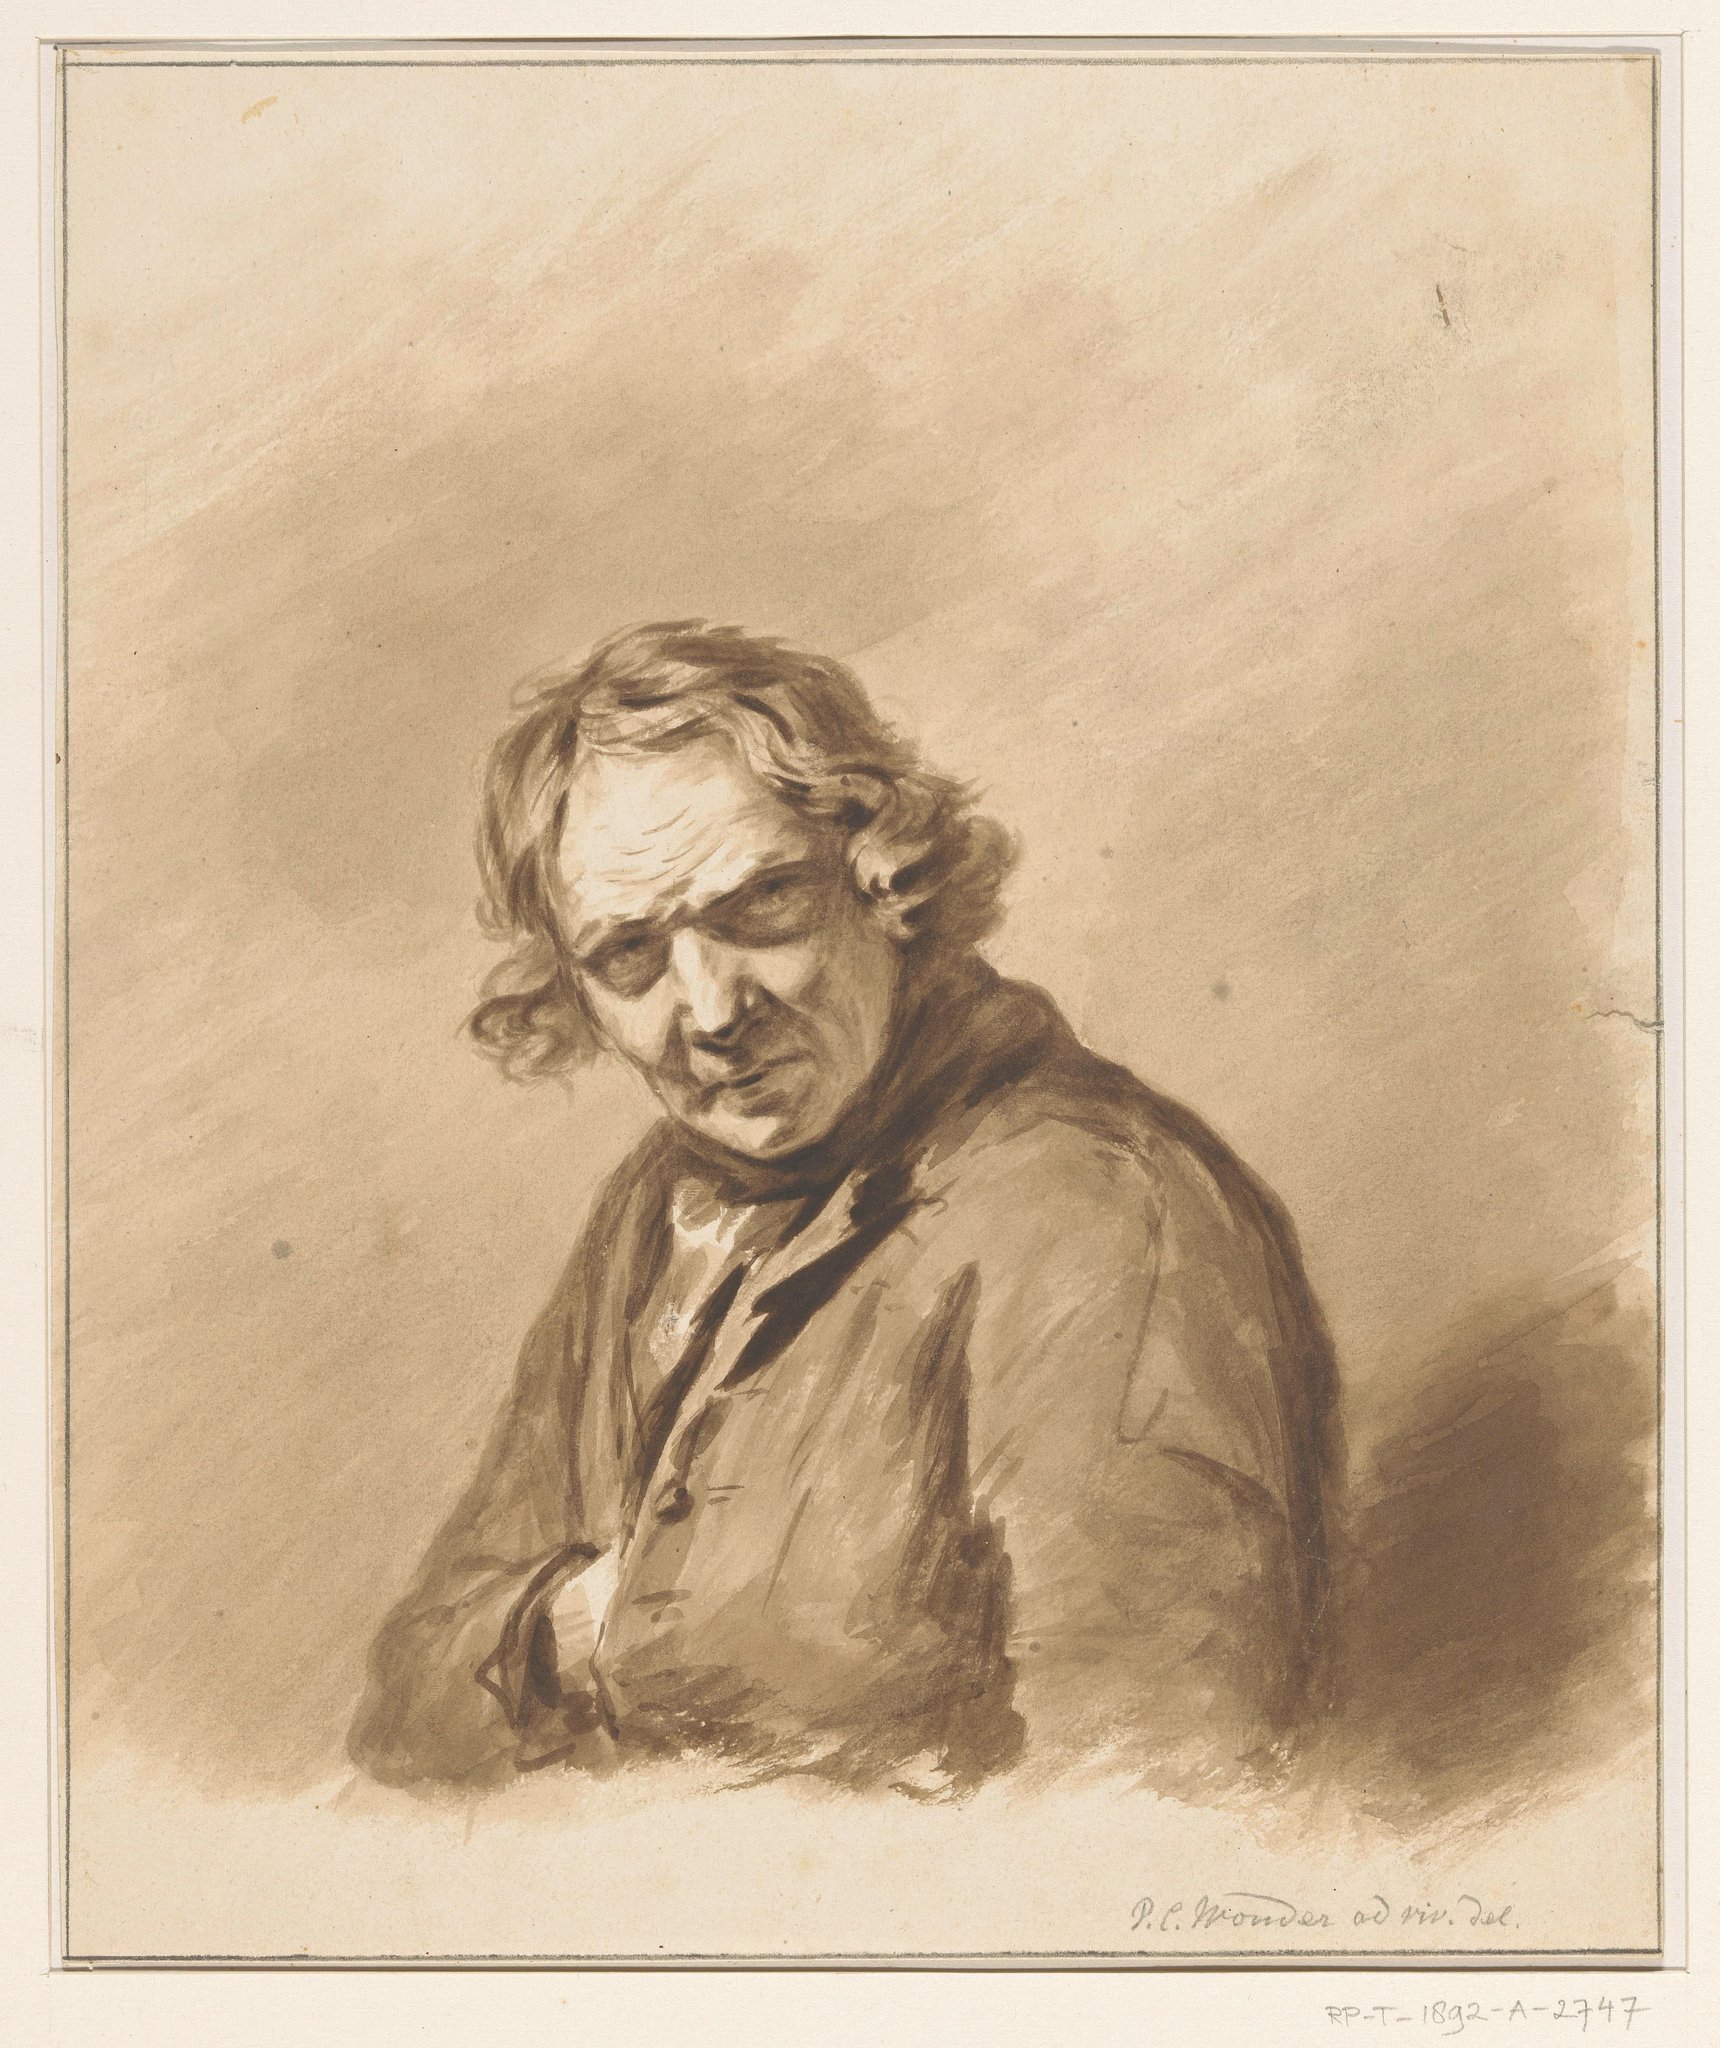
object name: drawing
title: Portret van Lourens van Schaick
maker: pieter christoffel wonder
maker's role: draughtsman, painter, print maker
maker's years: 1780-1852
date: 1790-1852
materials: paper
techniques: brush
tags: historical persons